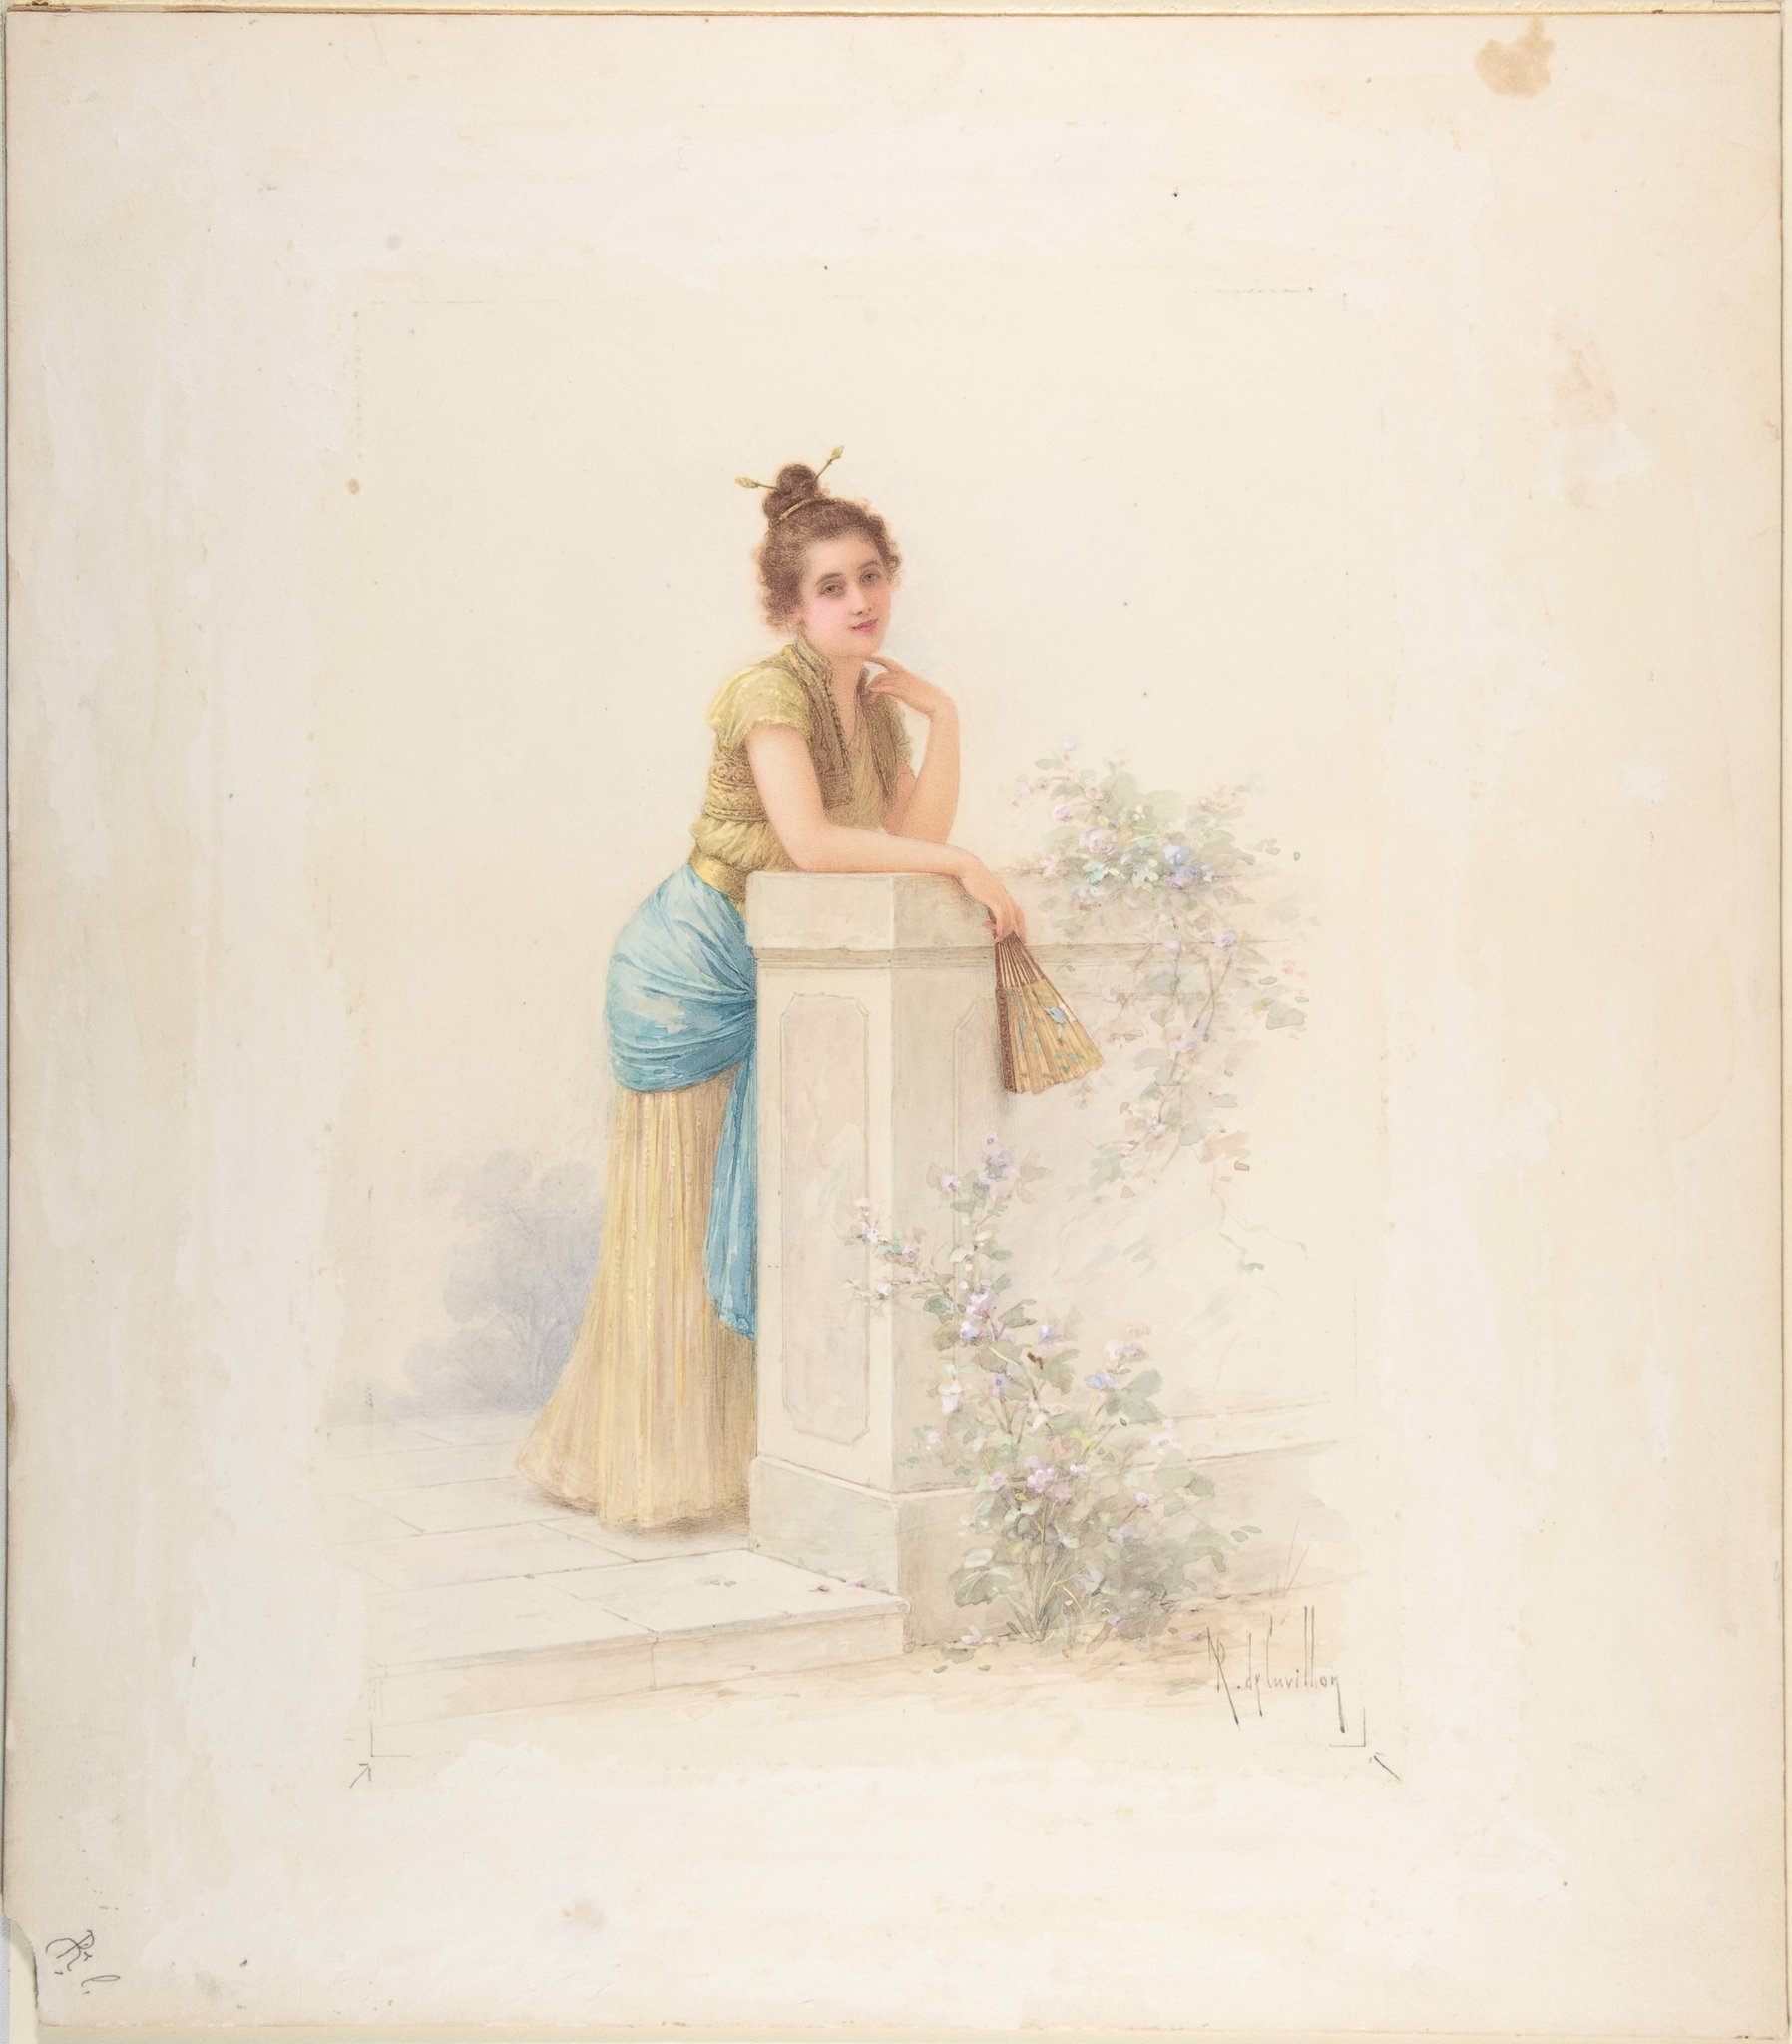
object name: drawing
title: Lady with a Fan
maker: louis-robert cuvillon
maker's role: artist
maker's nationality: french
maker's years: 1848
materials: watercolor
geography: france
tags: fans,women